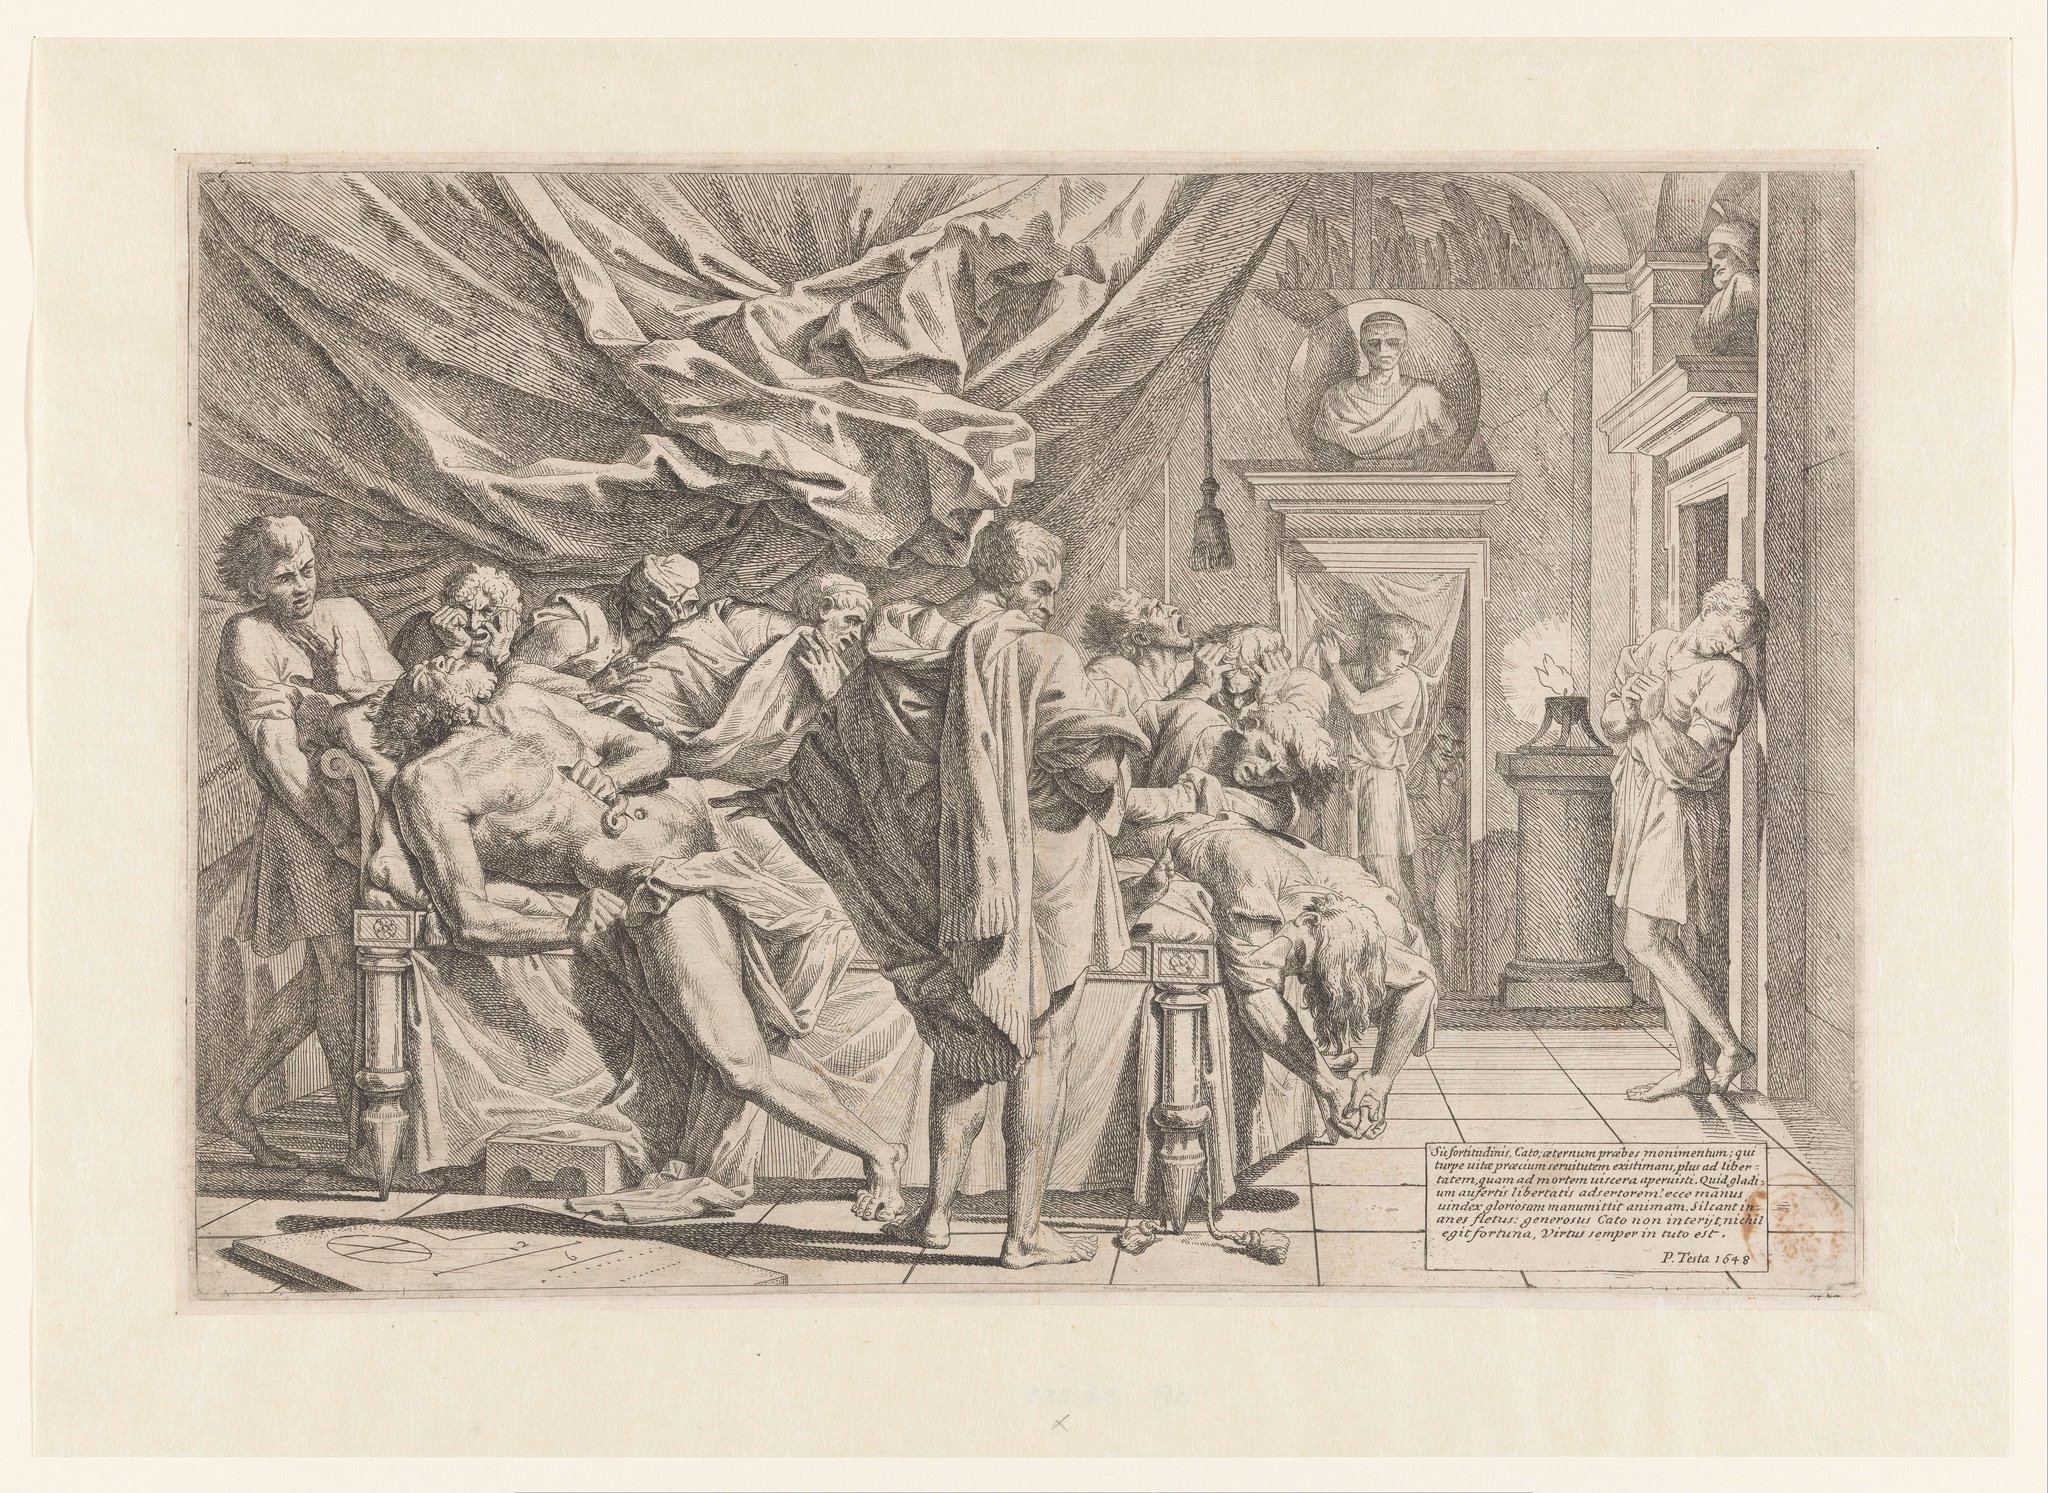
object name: print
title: Dood van Cato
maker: pietro testa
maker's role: draughtsman, painter, print maker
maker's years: 1611-1650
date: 1648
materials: paper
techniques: etching, intaglio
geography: italy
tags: death of marcus porcius cato the younger surnamed uticensis: he stabs himself on his couch, after reading plato's phaedo; he may be seen tearing out his entrails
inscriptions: collector's mark: Lugt 240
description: In zijn slaapvertrek heeft de staatsman Cato zichzelf doorstoken. Liggend op een bed trekt hij ingewanden uit zijn lichaam. Een groep omstanders kijkt verafschuwd toe. Zeven regels Latijnse tekst in ondermarge.